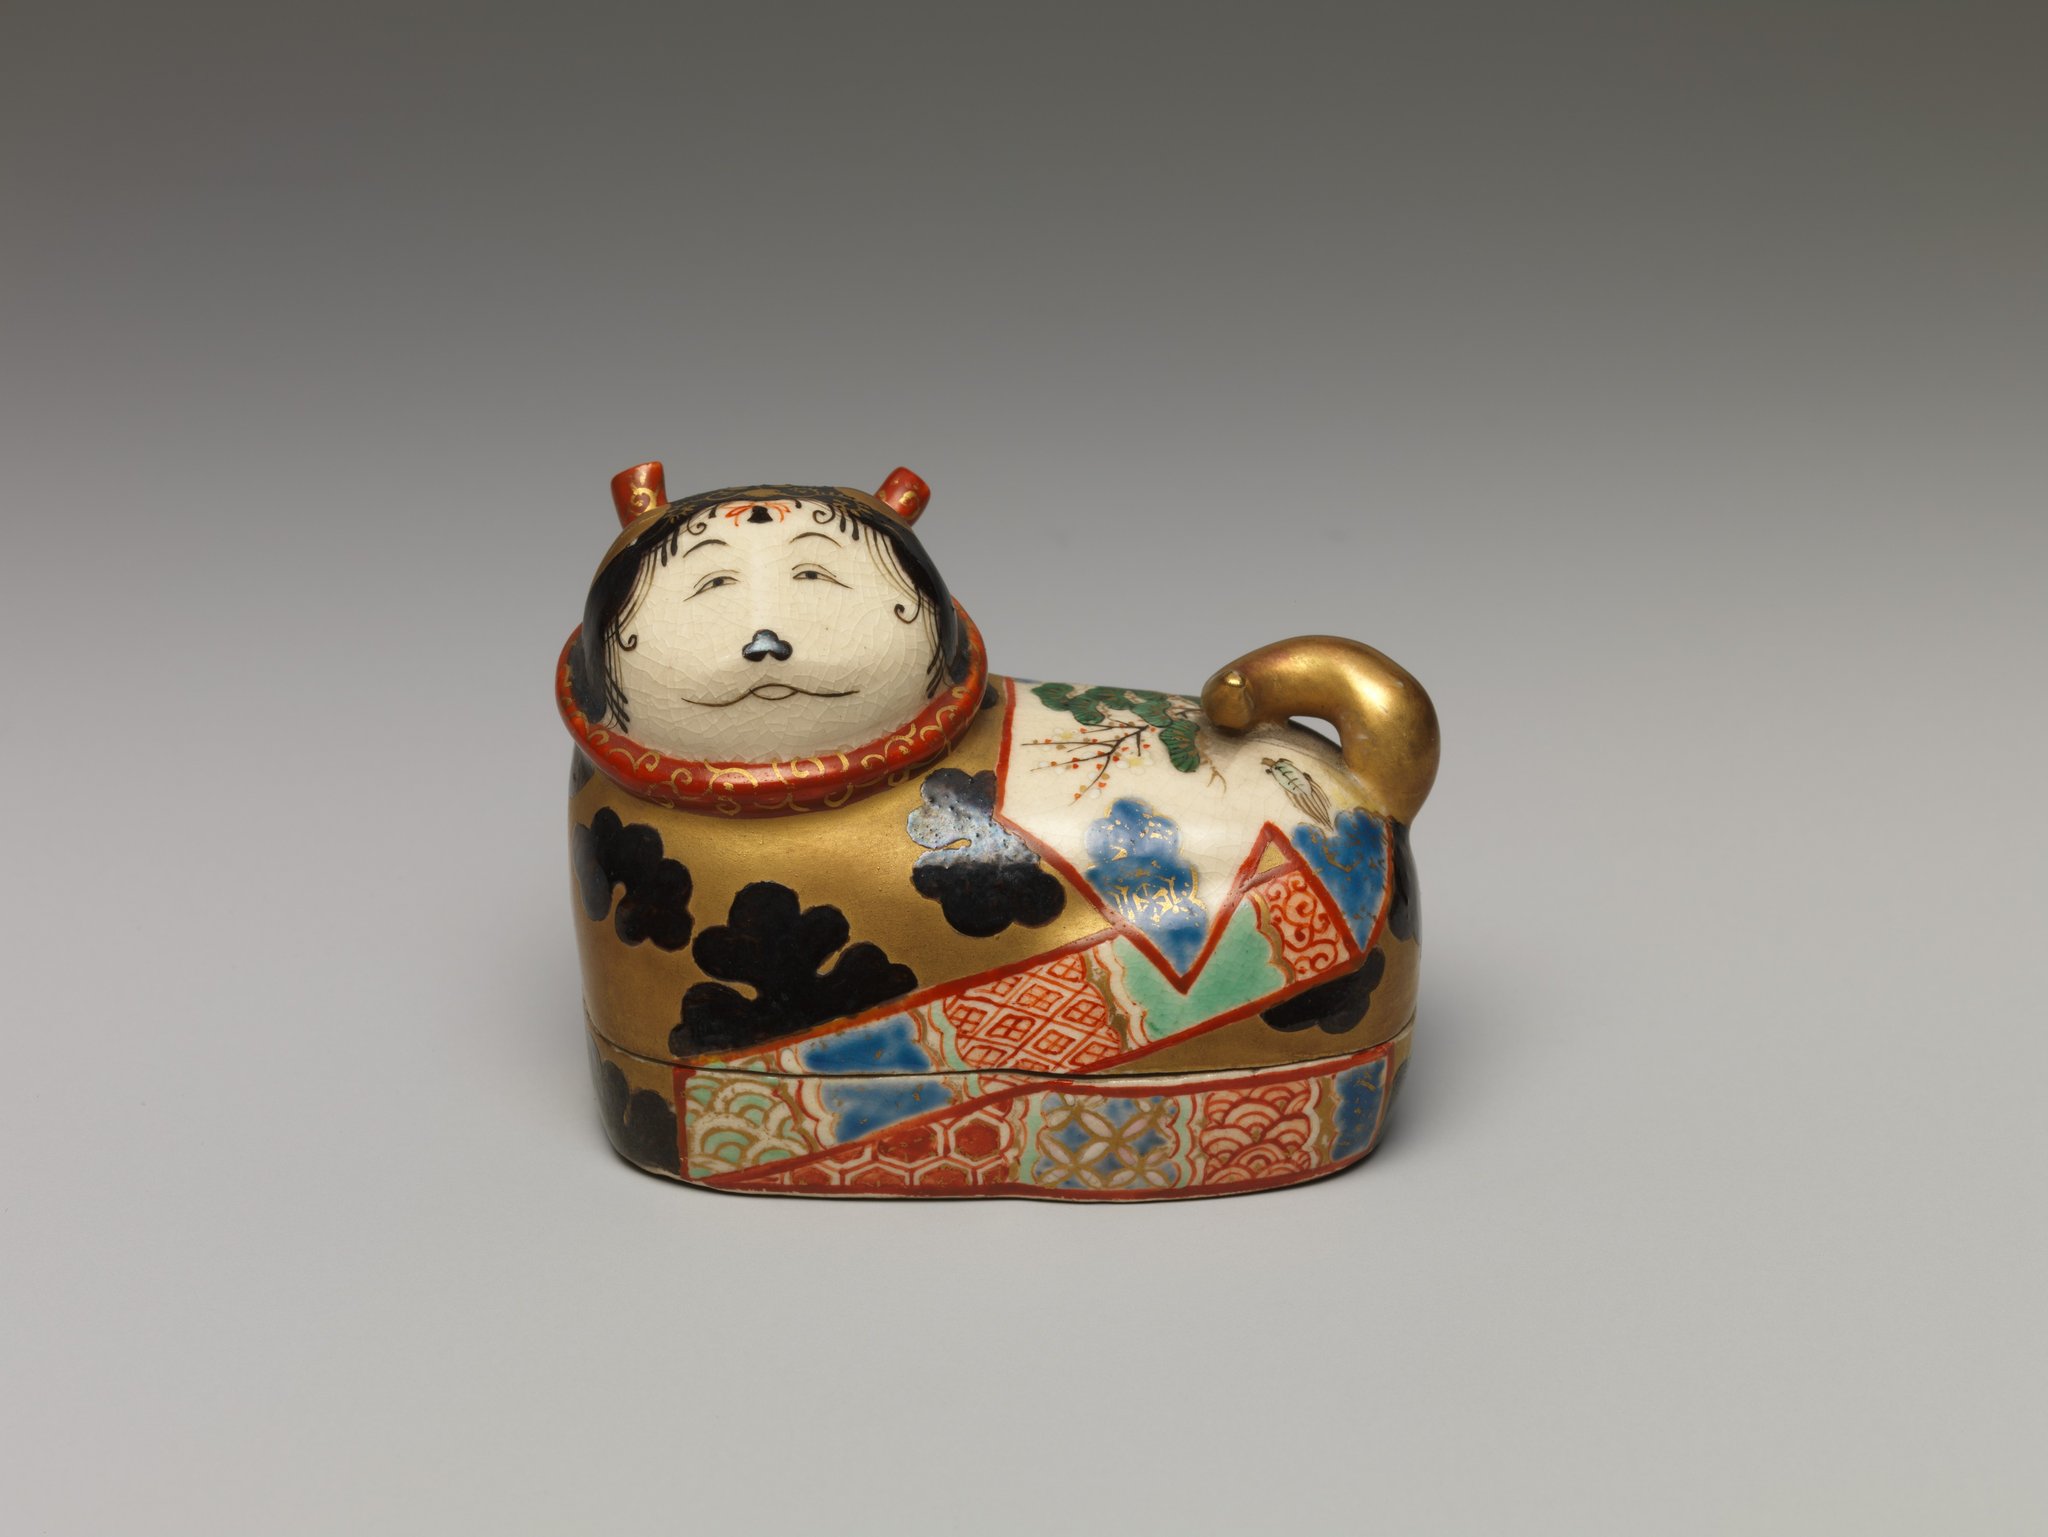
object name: incense box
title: One of a Pair of Incense Boxes in the Shape of Dog Charms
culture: japanese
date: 1840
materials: enamel, porcelain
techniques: overglaze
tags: dogs